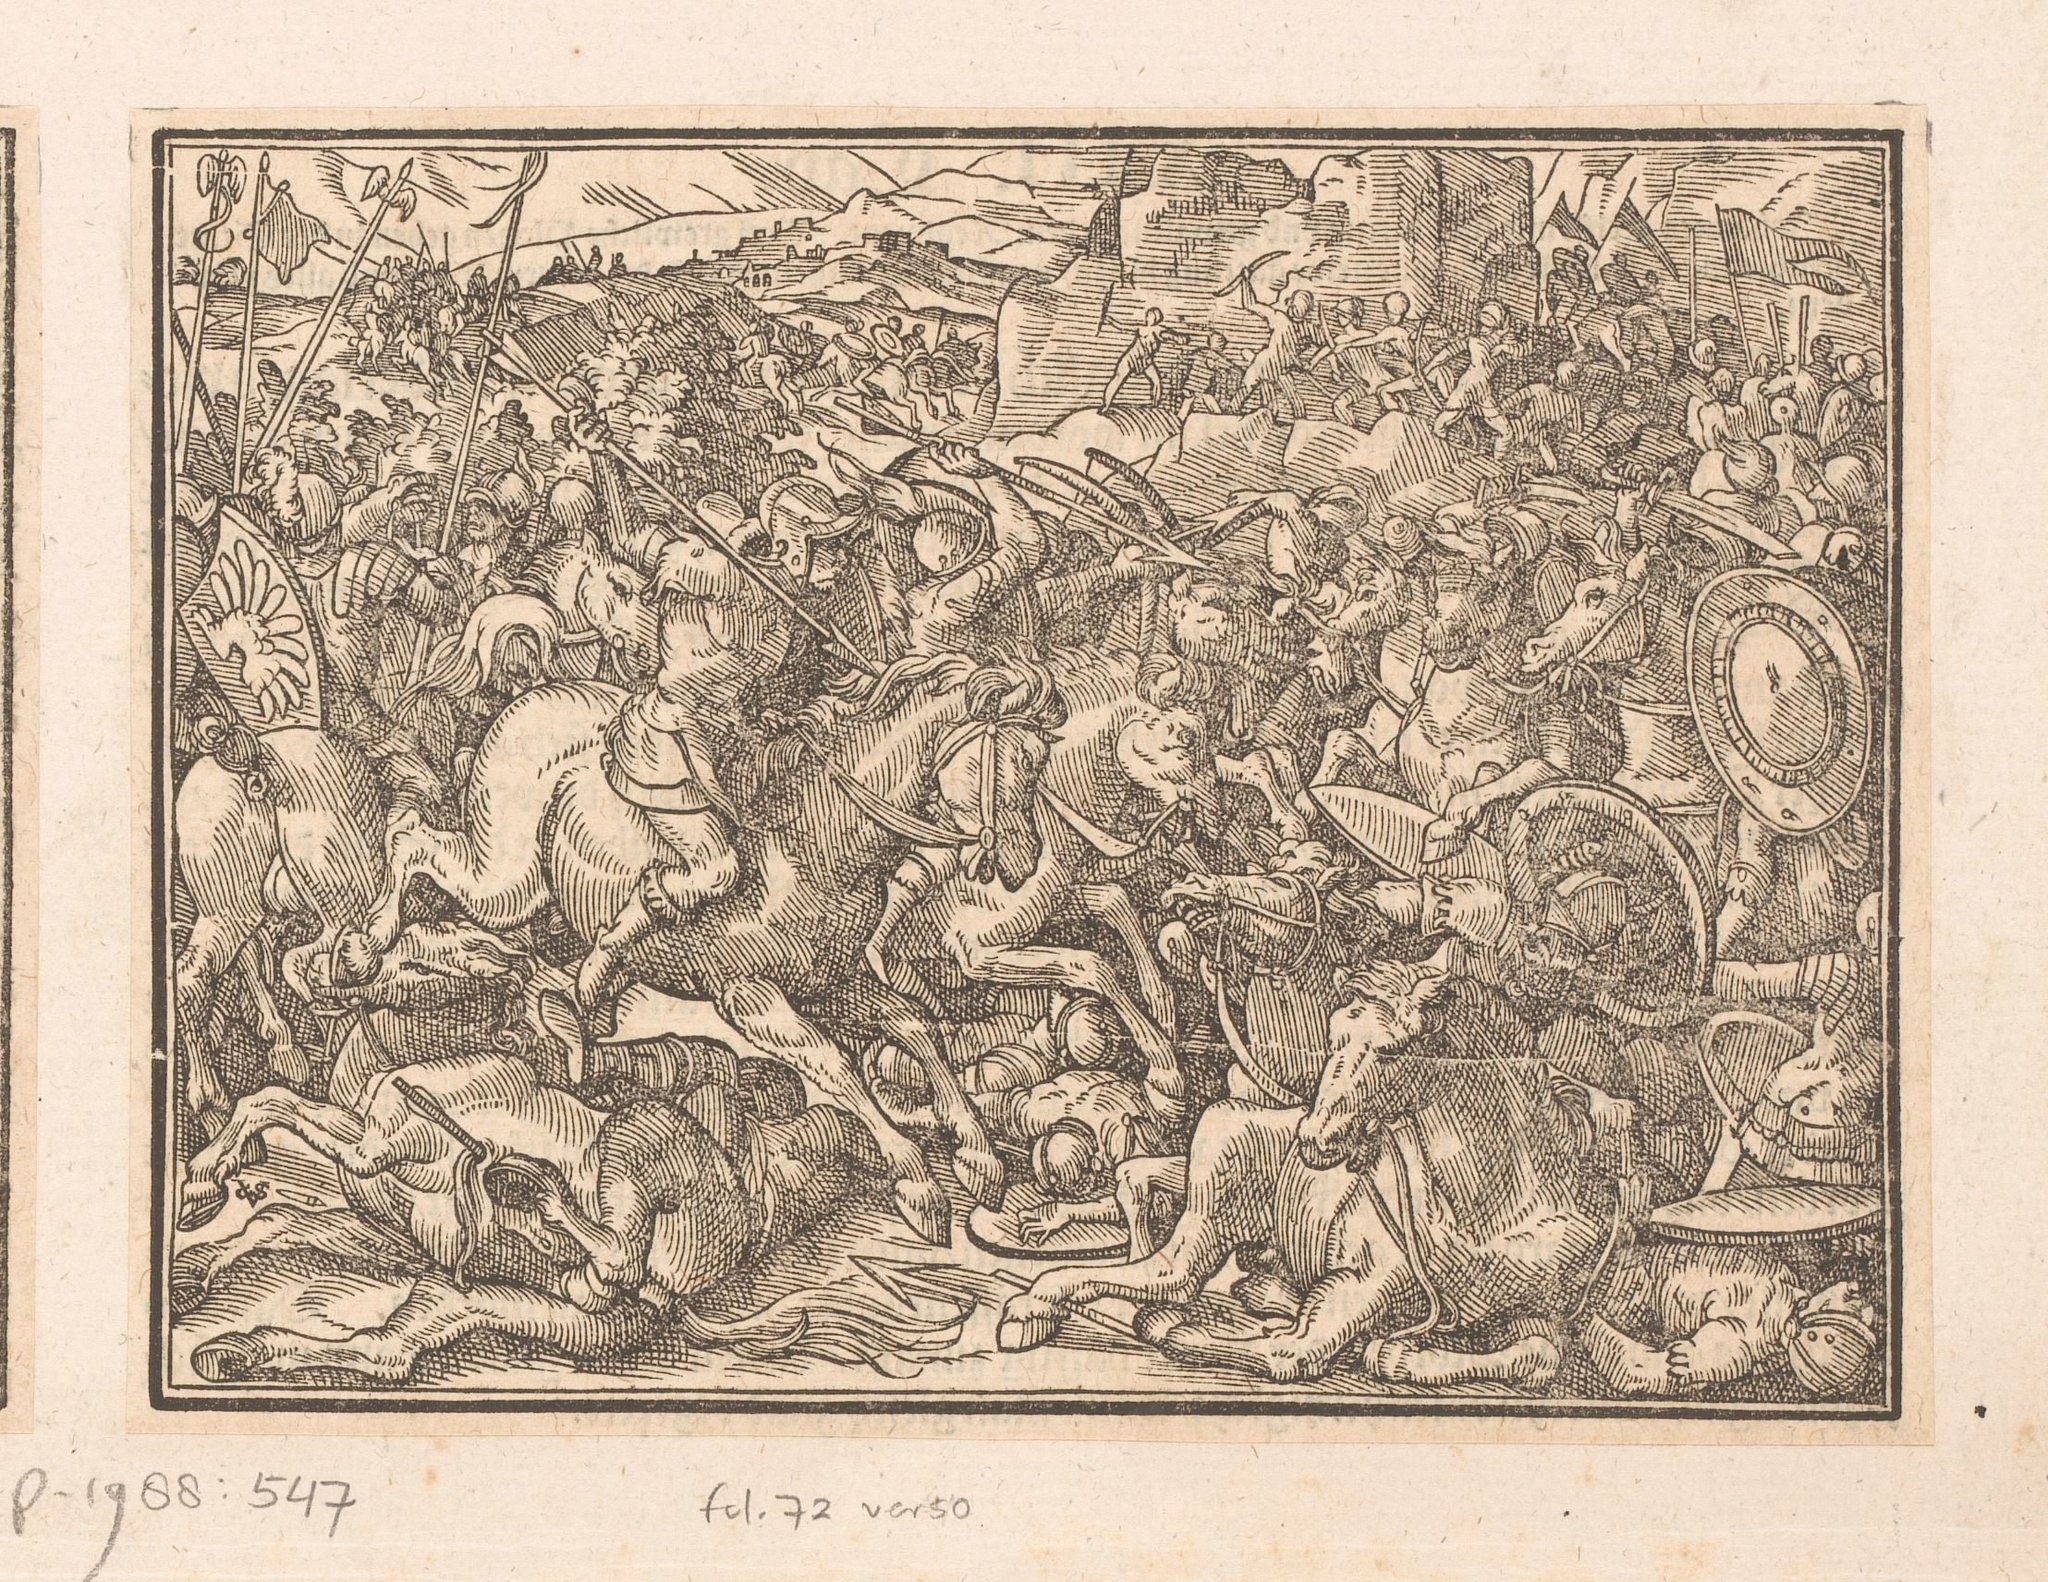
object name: book illustration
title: Placidus verslaat de Gadarenen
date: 1574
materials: paper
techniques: woodcut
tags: old testament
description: Prent voor het eerst gebruikt in: Josephus, Flavius. Historien und Bücher von Alten Jüdischen Geschichten. Straatsburg: Theodosius Rihel, 1574.